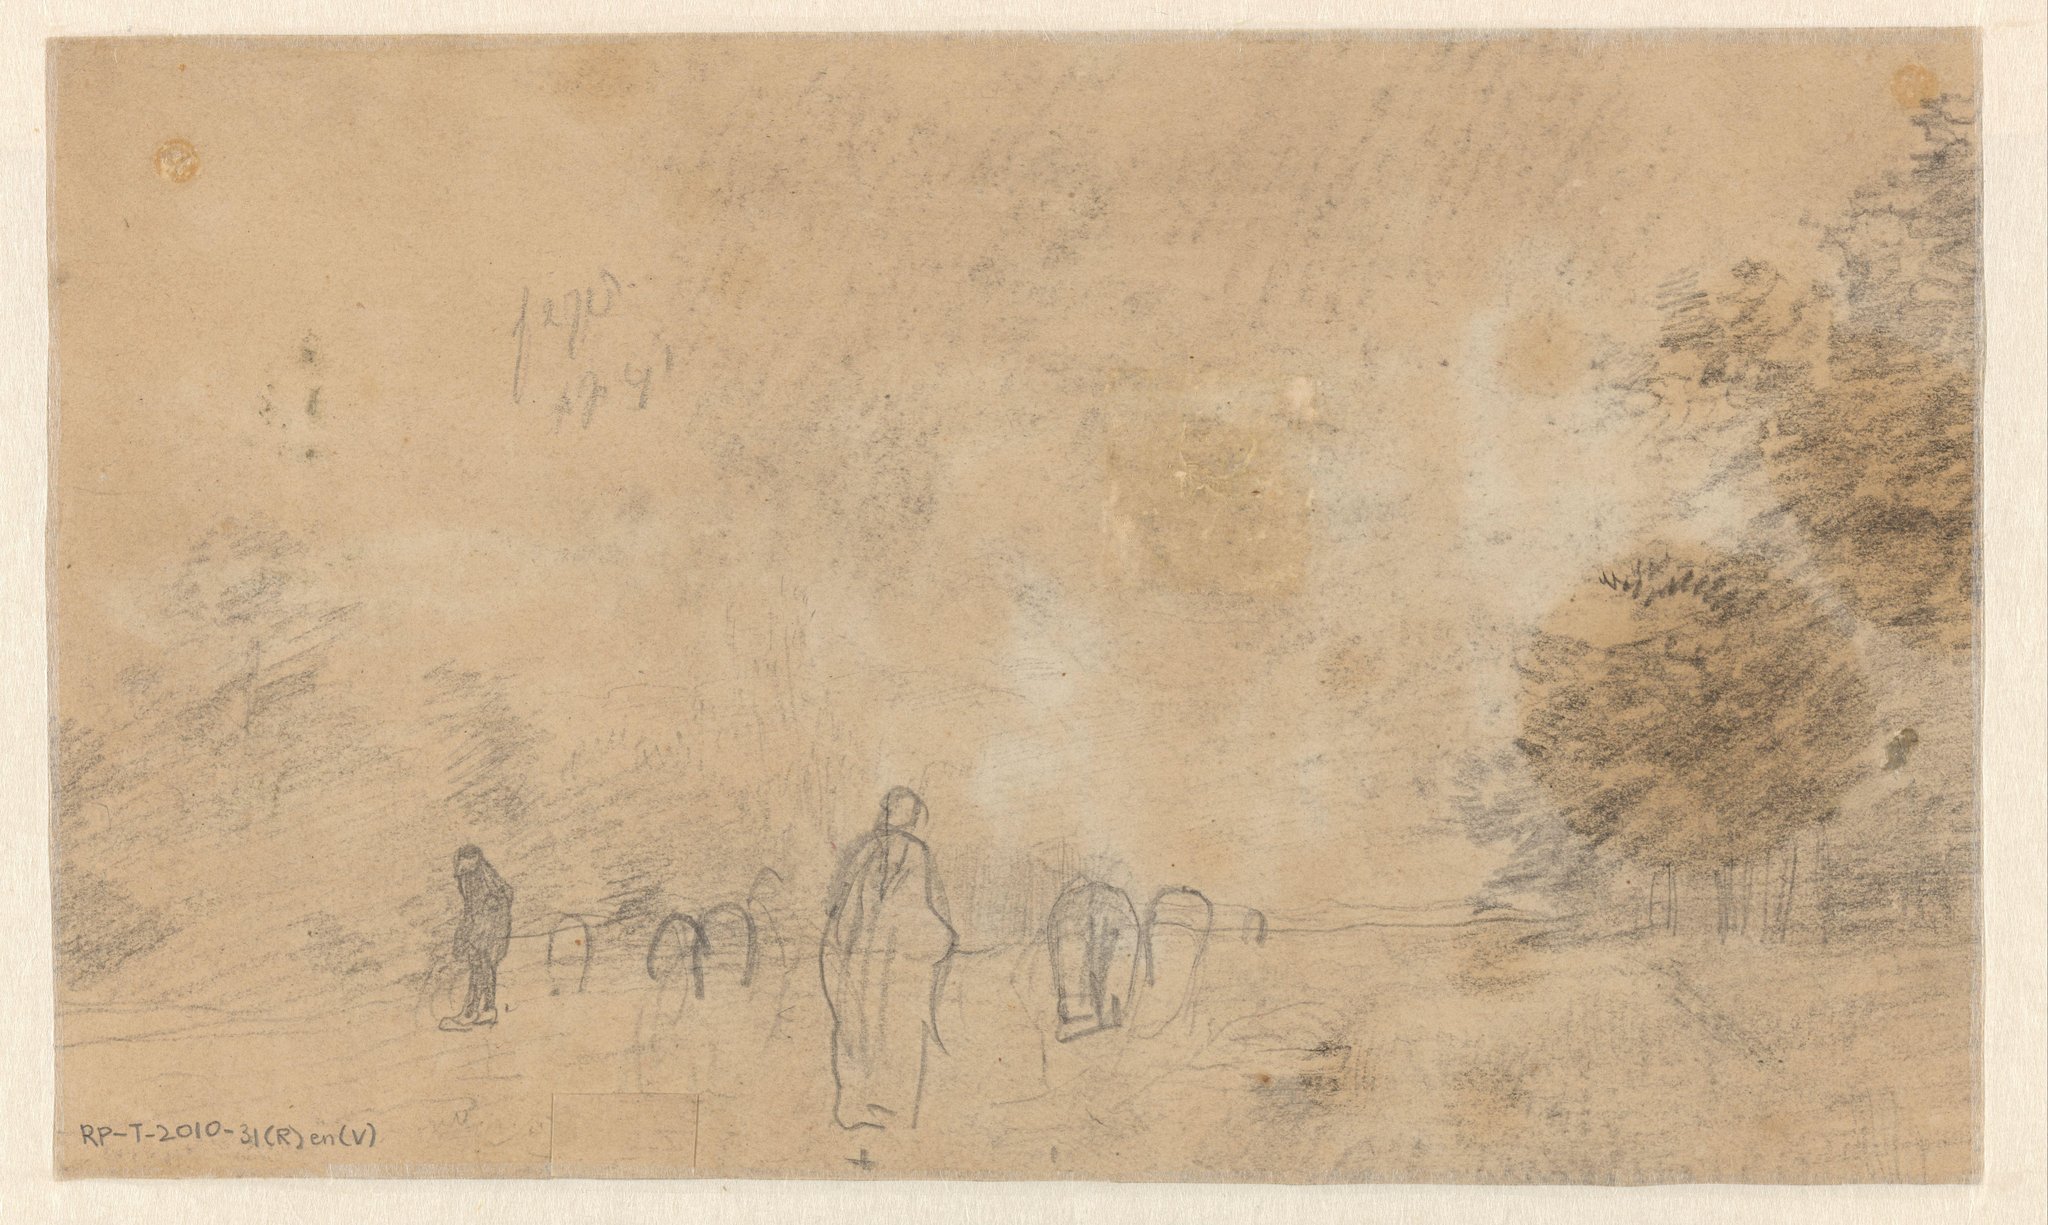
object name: drawing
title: Landweg met bomen, figuren en vee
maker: anton mauve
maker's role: draughtsman, painter, print maker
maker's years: 1838-1888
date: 1879-1884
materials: chalk, paper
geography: netherlands